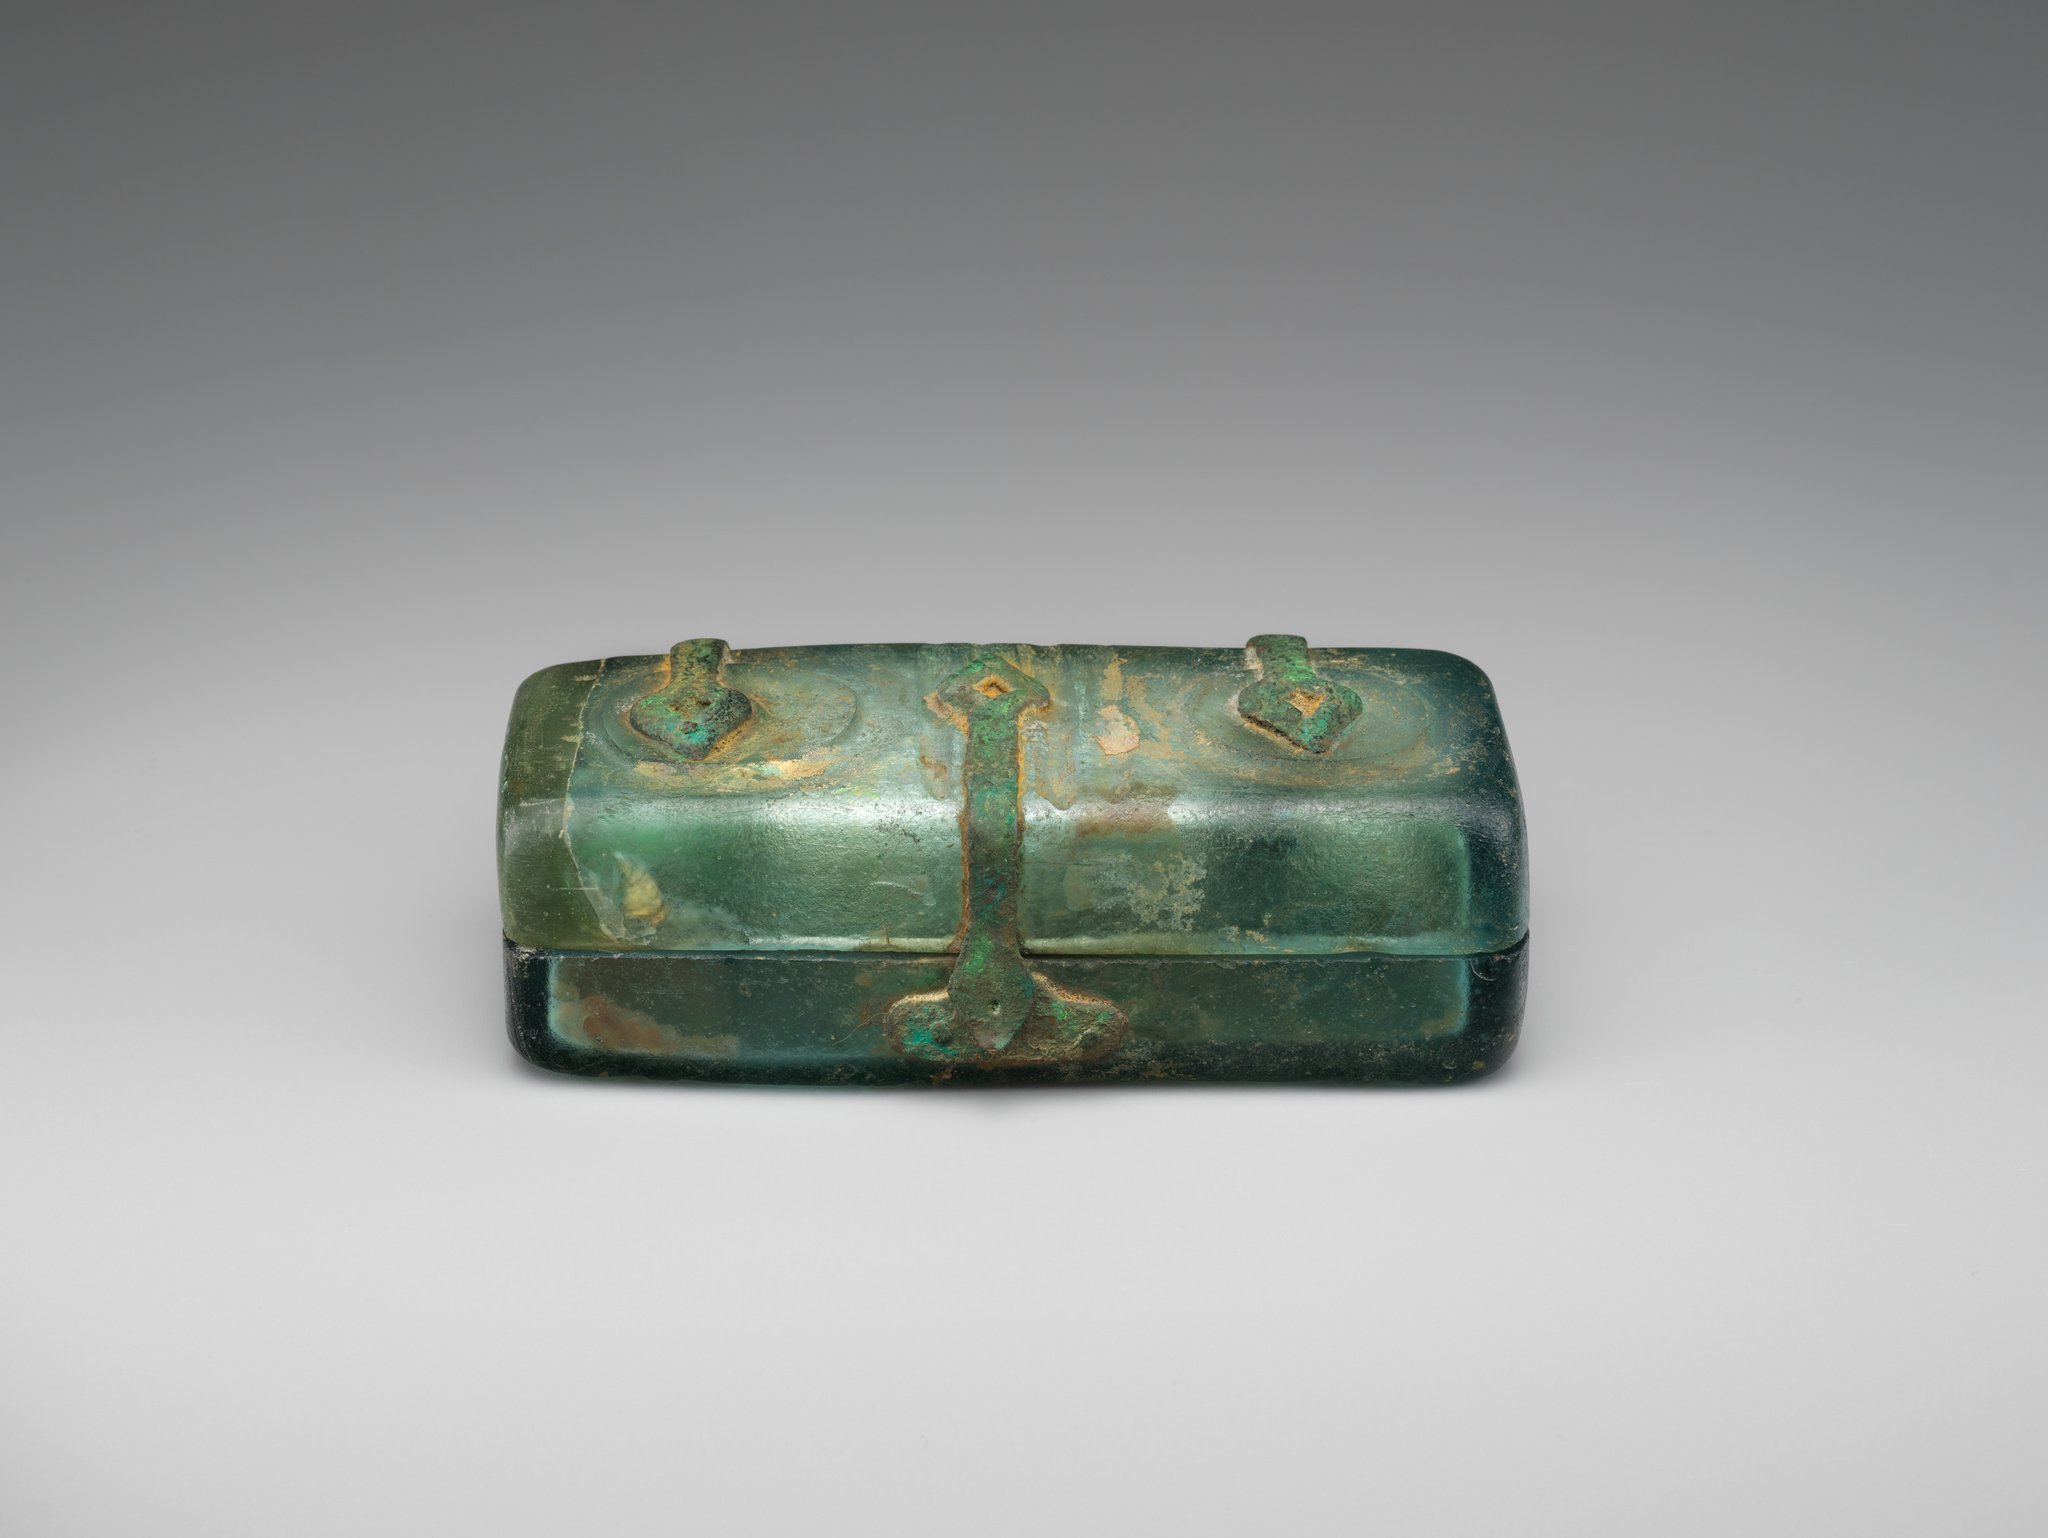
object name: box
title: Box with Metal Mounts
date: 1001-1100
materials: glass, metal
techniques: glassblowing, cutting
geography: egypt